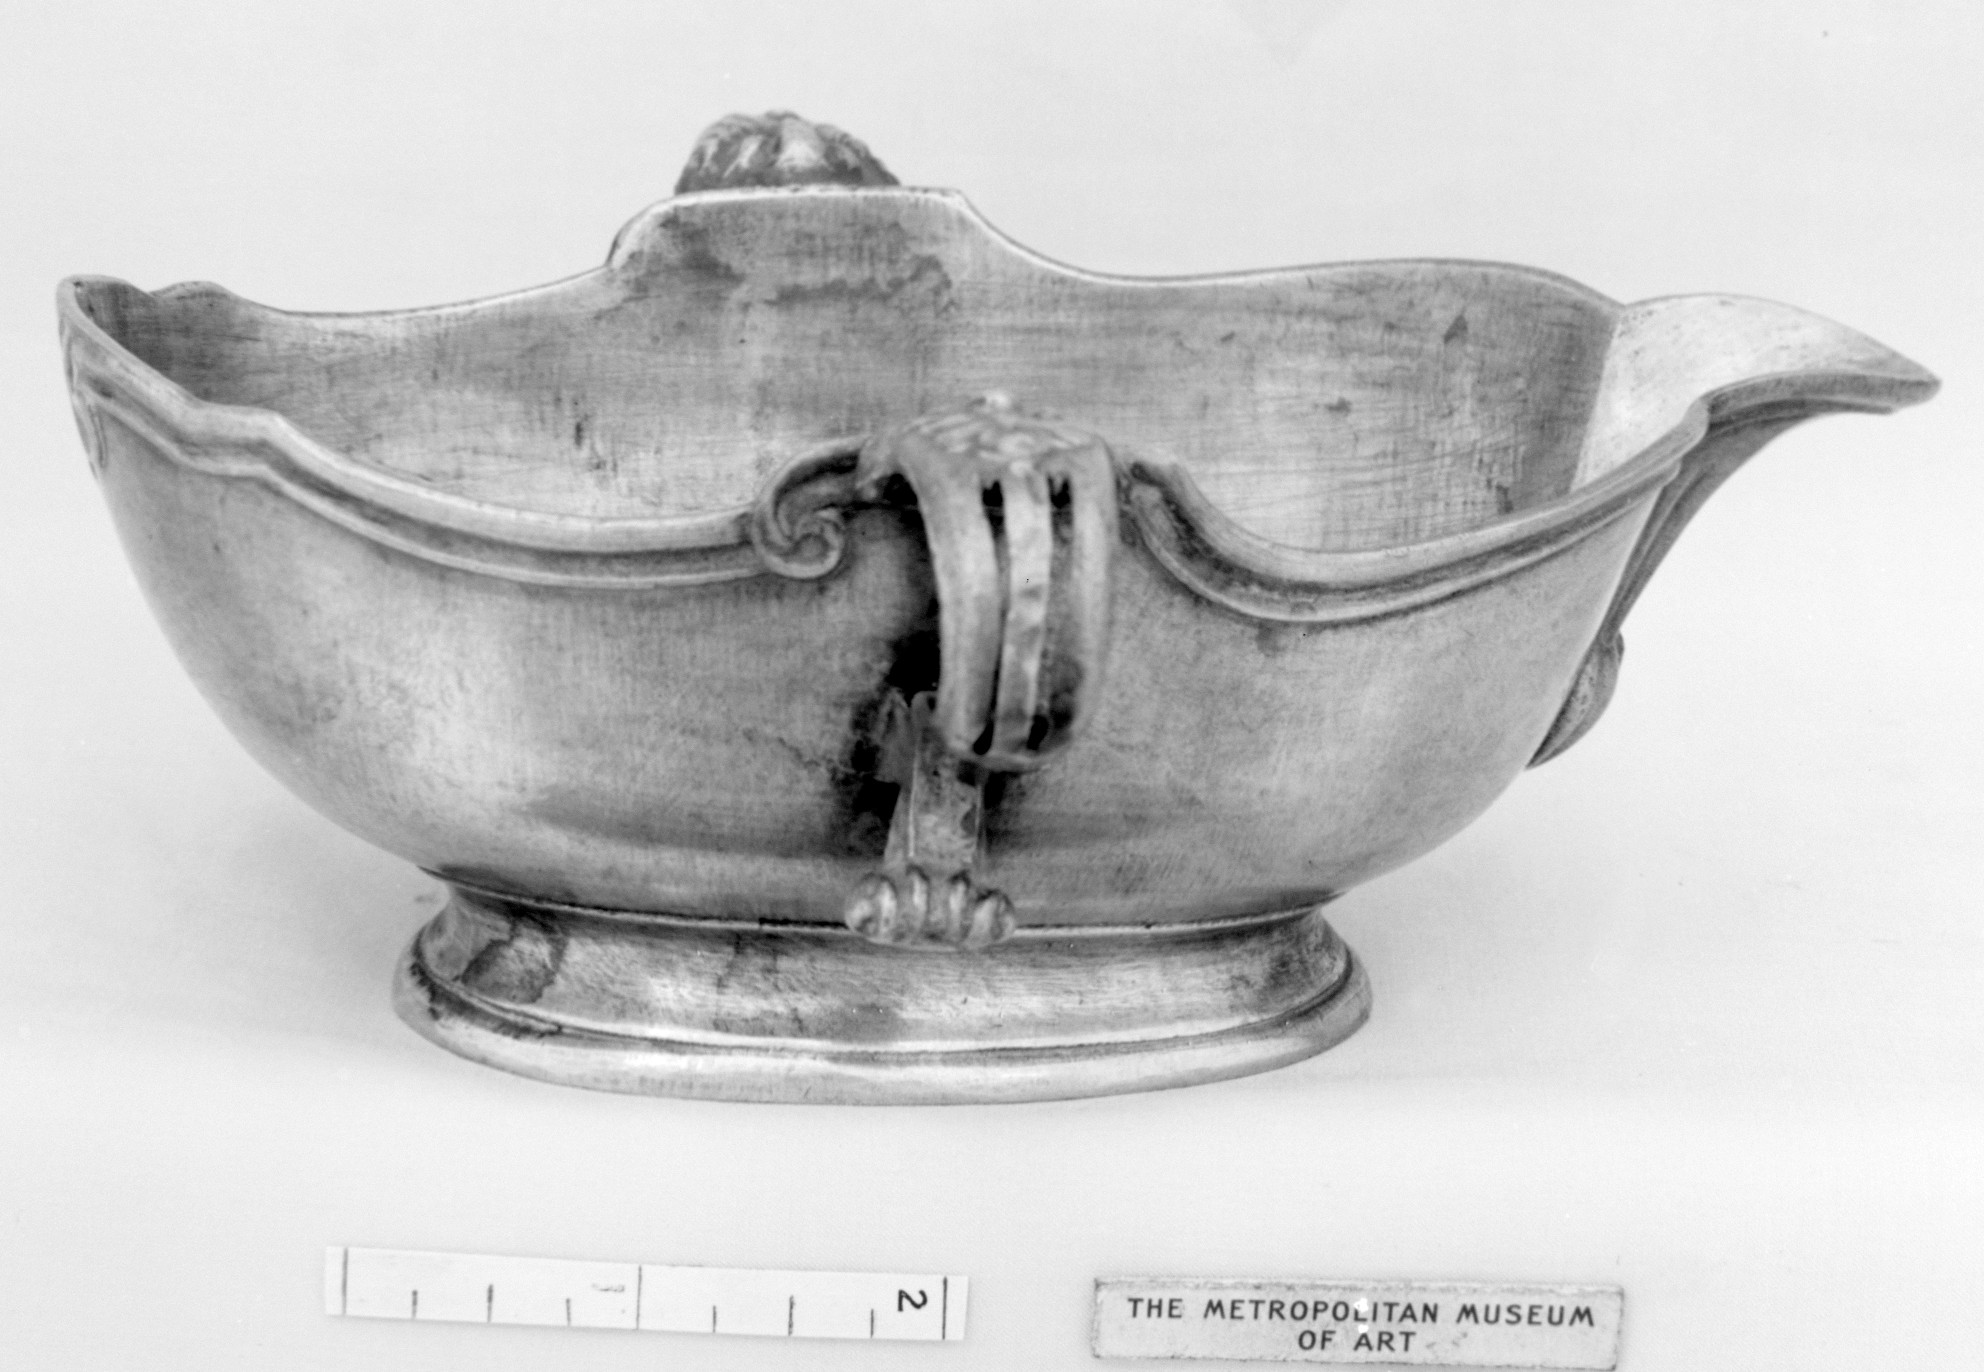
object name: sauceboat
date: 1701-1733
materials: pewter